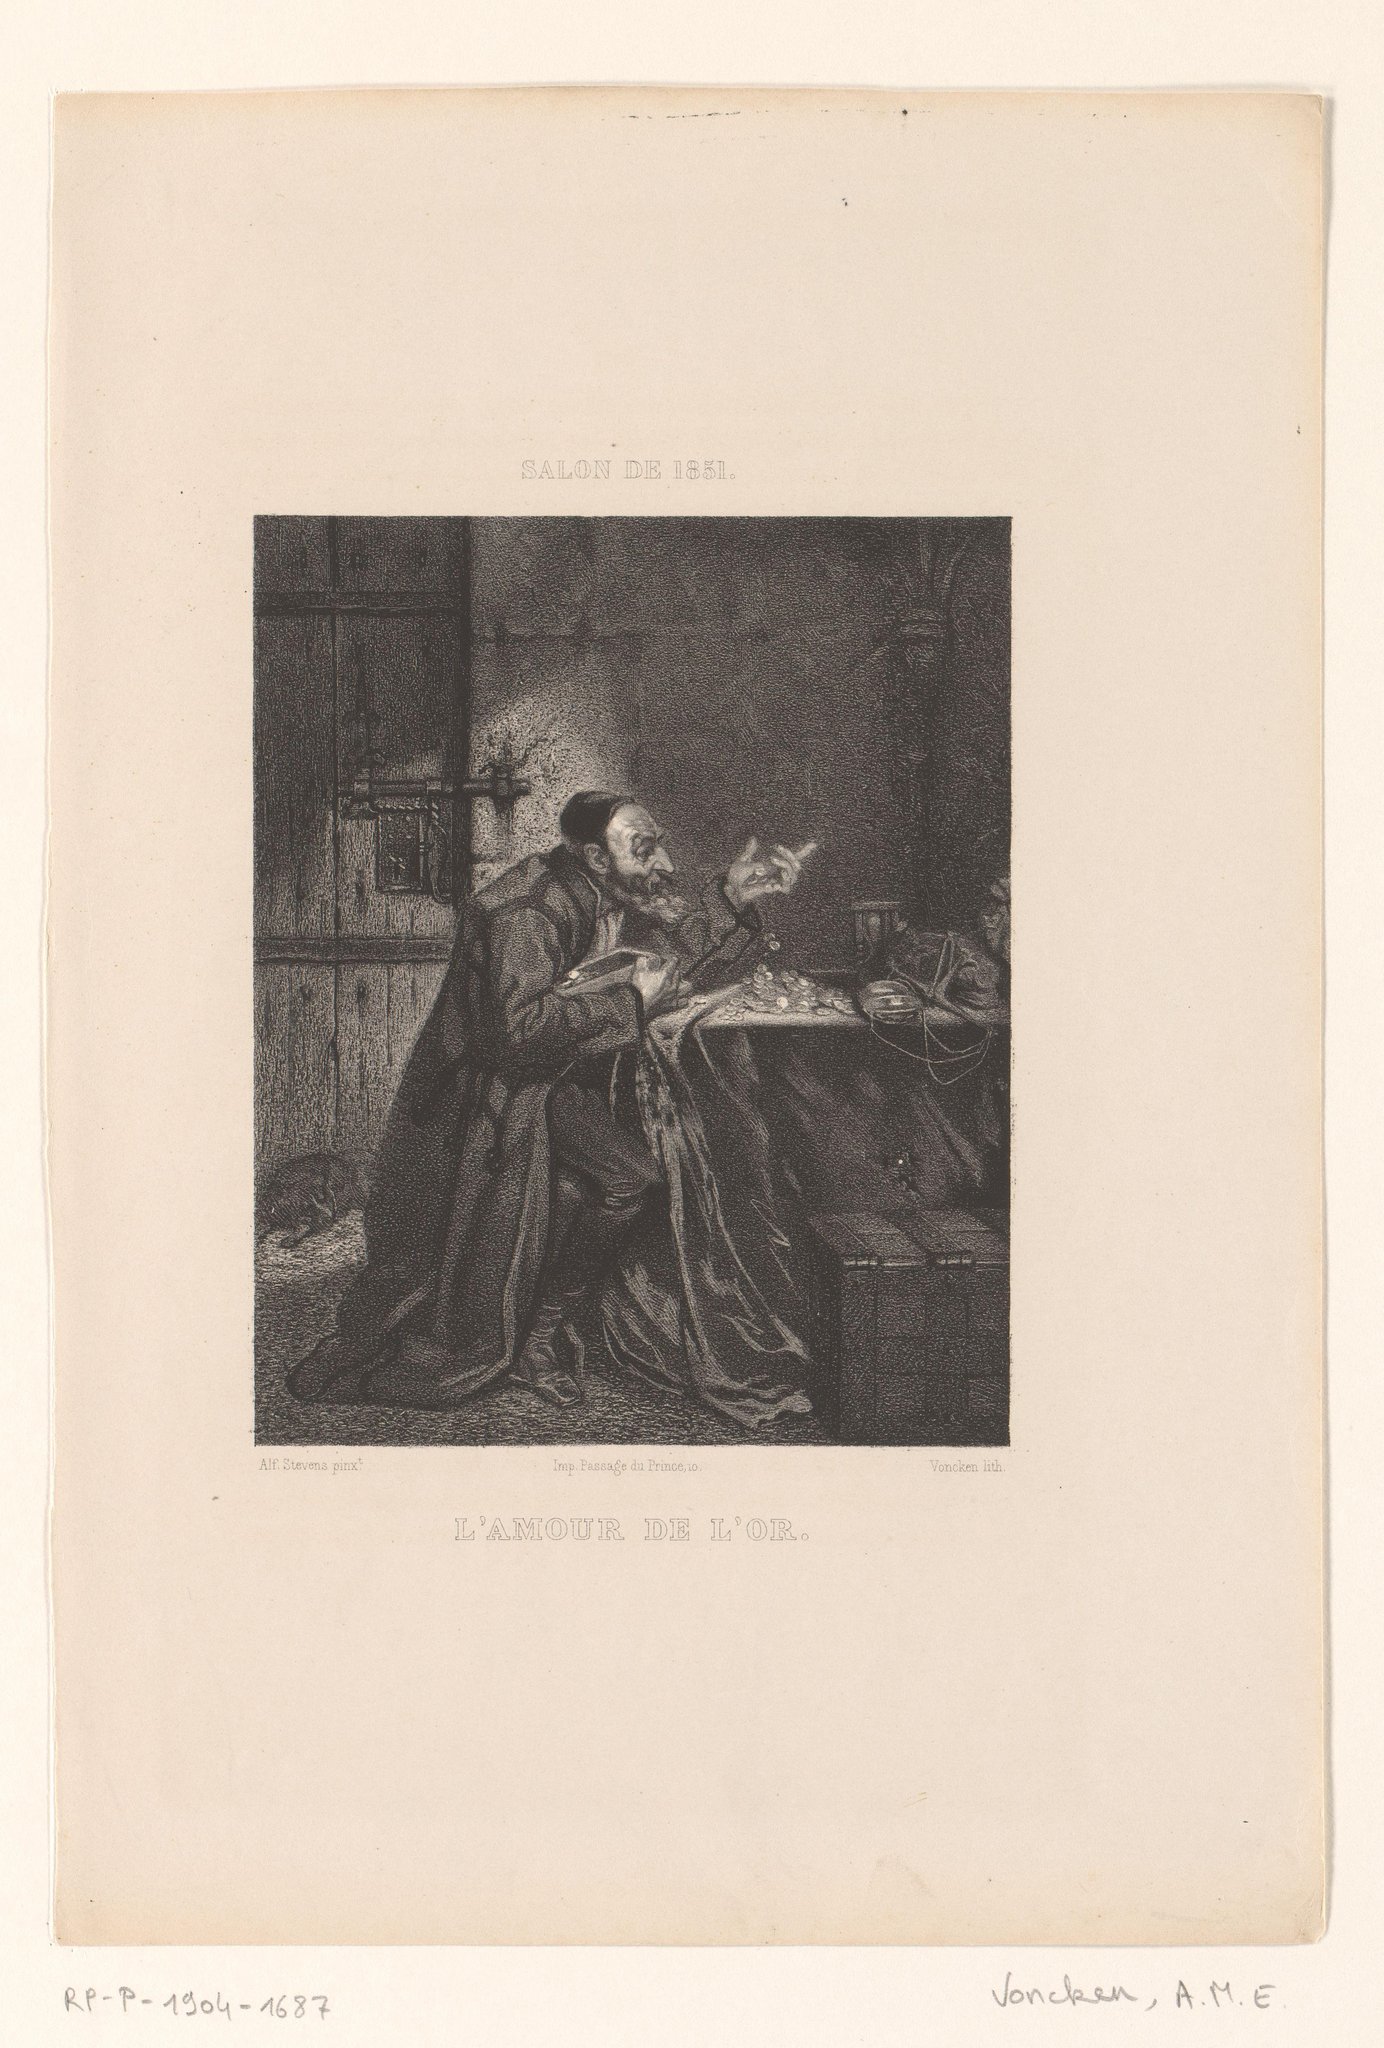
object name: print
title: Oude man met munten gezeten aan een tafel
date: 1851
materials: paper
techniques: lithograph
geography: brussels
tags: old man, coin, money-chest, treasure-chest, money-box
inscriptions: collector's mark: Lugt 2228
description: Het schilderij van Alfred Stevens hing in 1851 op de Salon van Brussel.